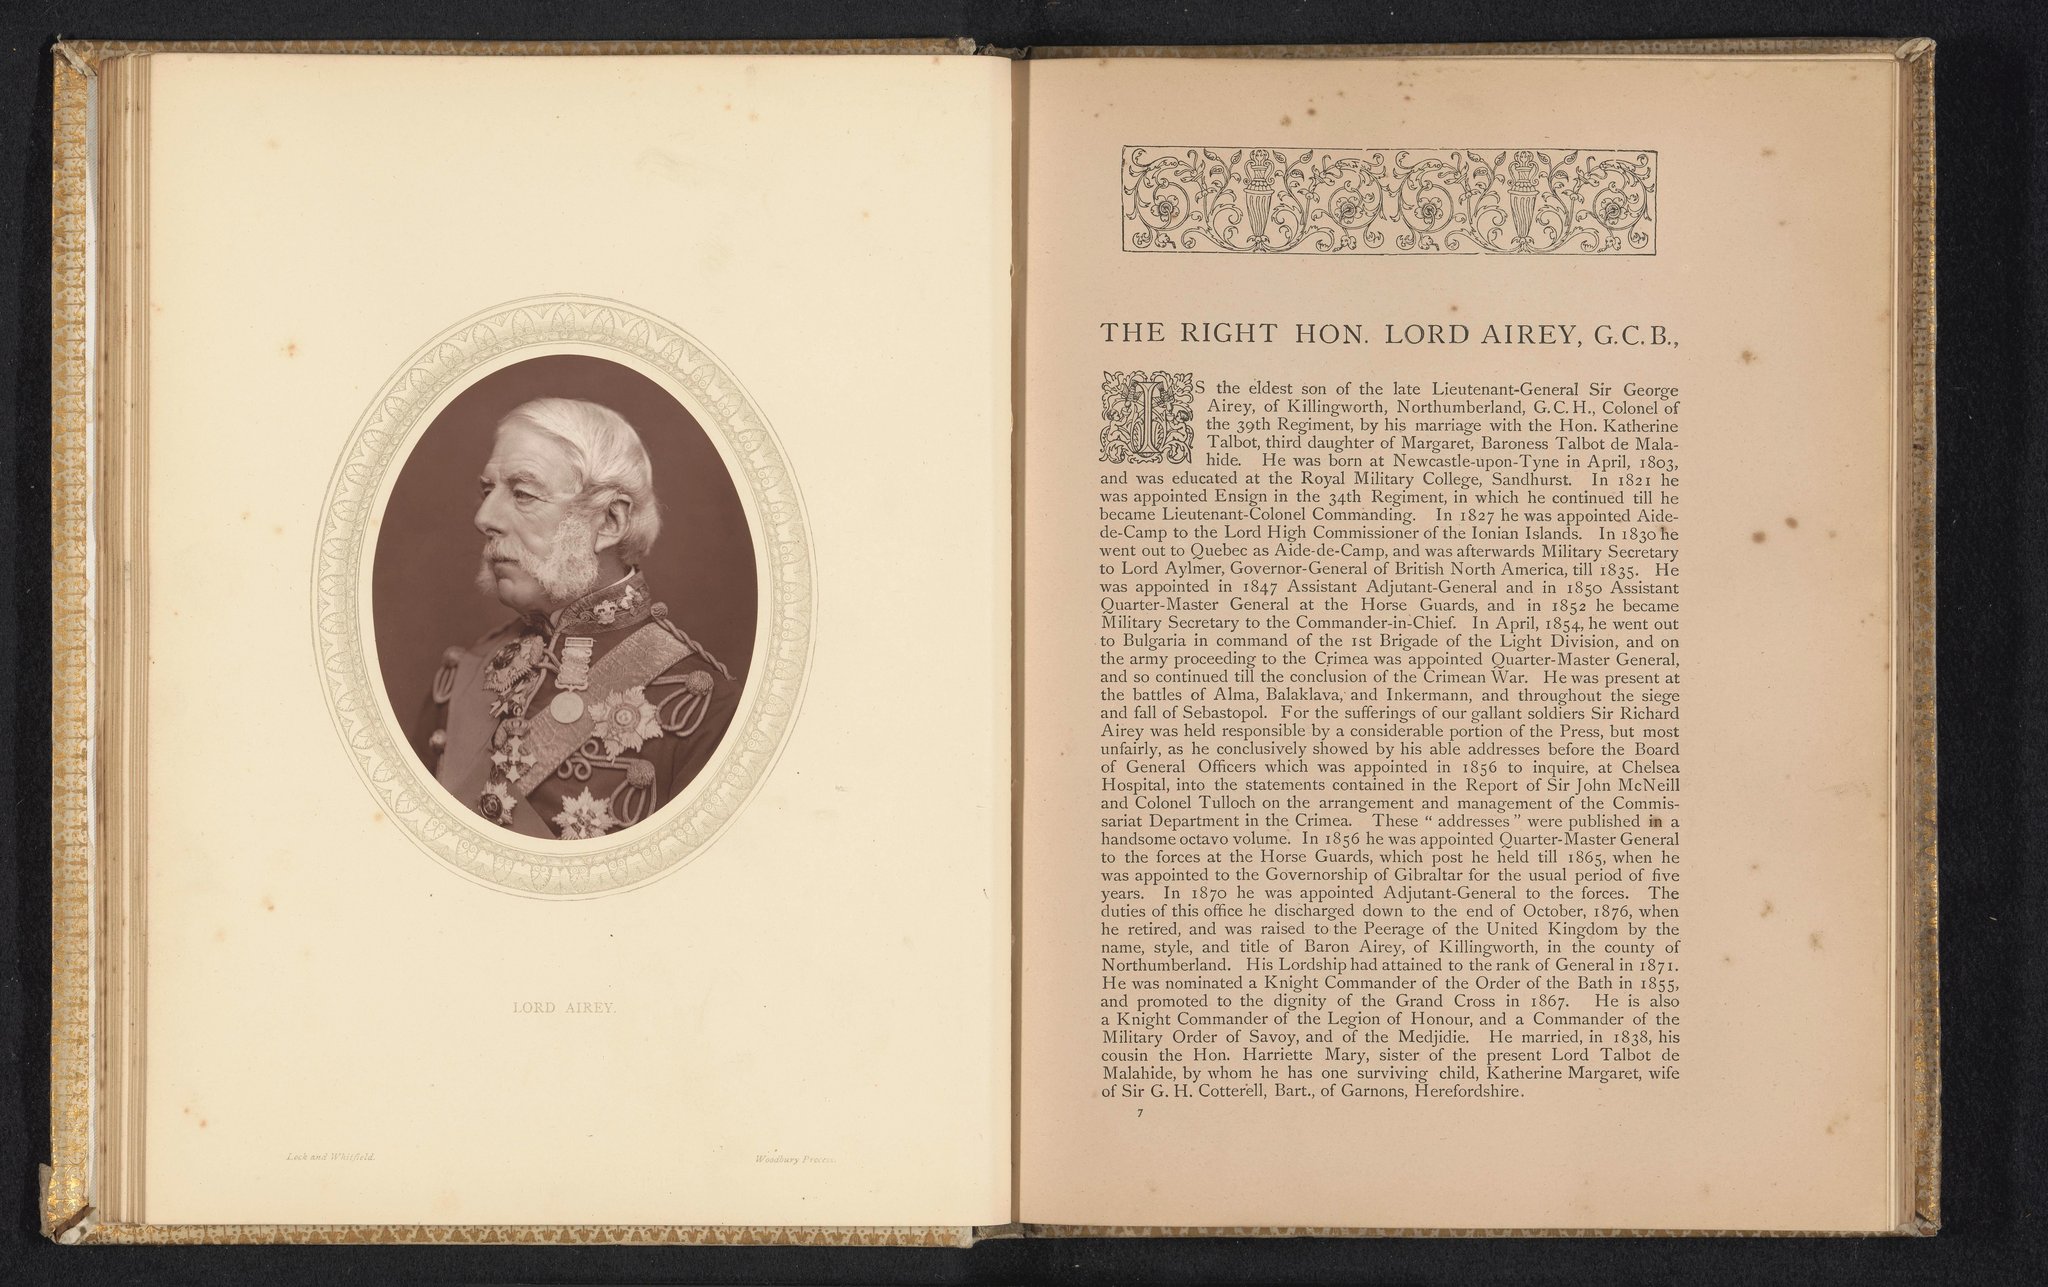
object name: photomechanical print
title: Lord Airey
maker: Anonymous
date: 1873-1878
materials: paper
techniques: woodburytype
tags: historical persons (portraits and scenes from the life) (+ (full) bust portrait), officer